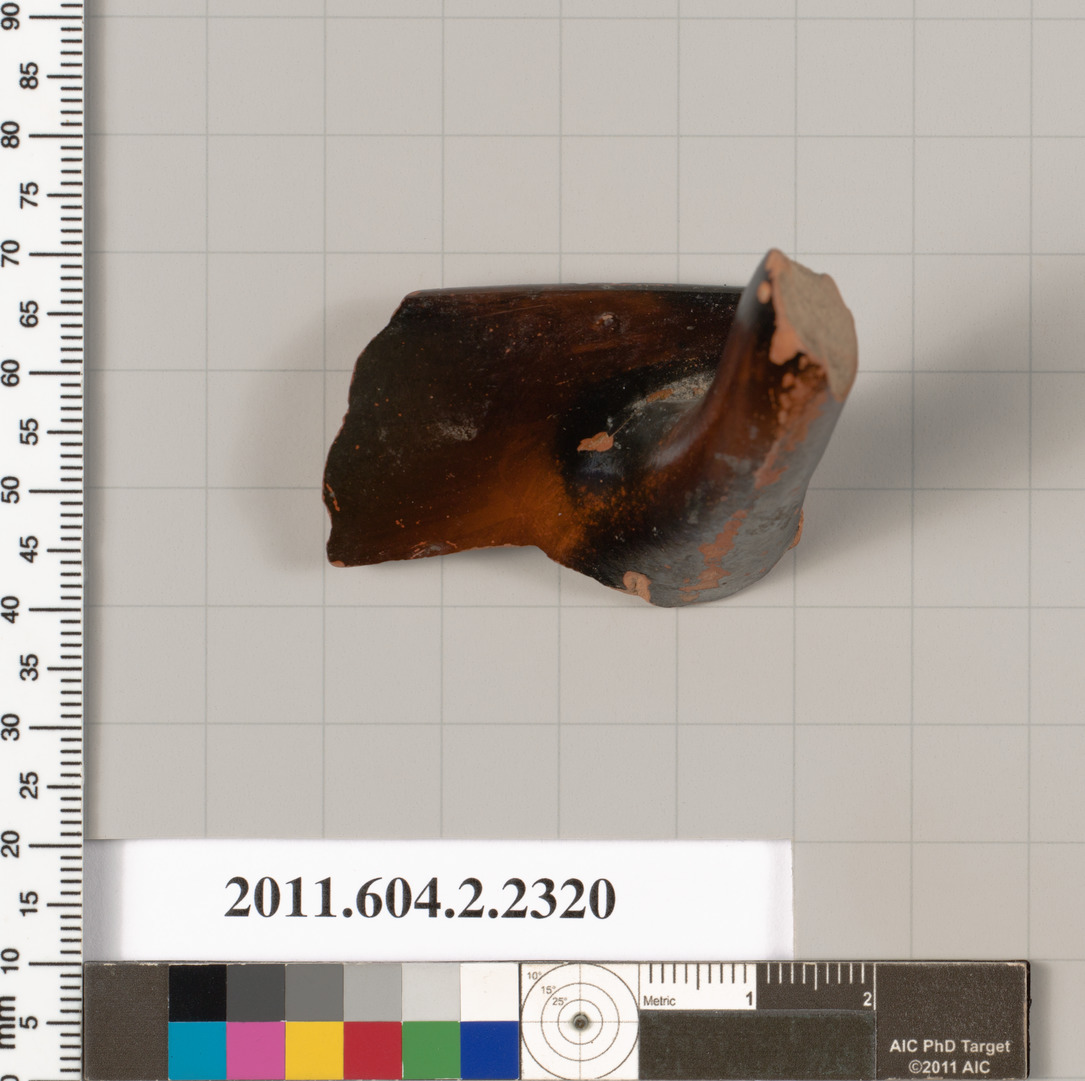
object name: skyphos fragment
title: Terracotta fragment of a skyphos (deep drinking cup)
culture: greek, attic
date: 600-401 BCE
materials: terracotta